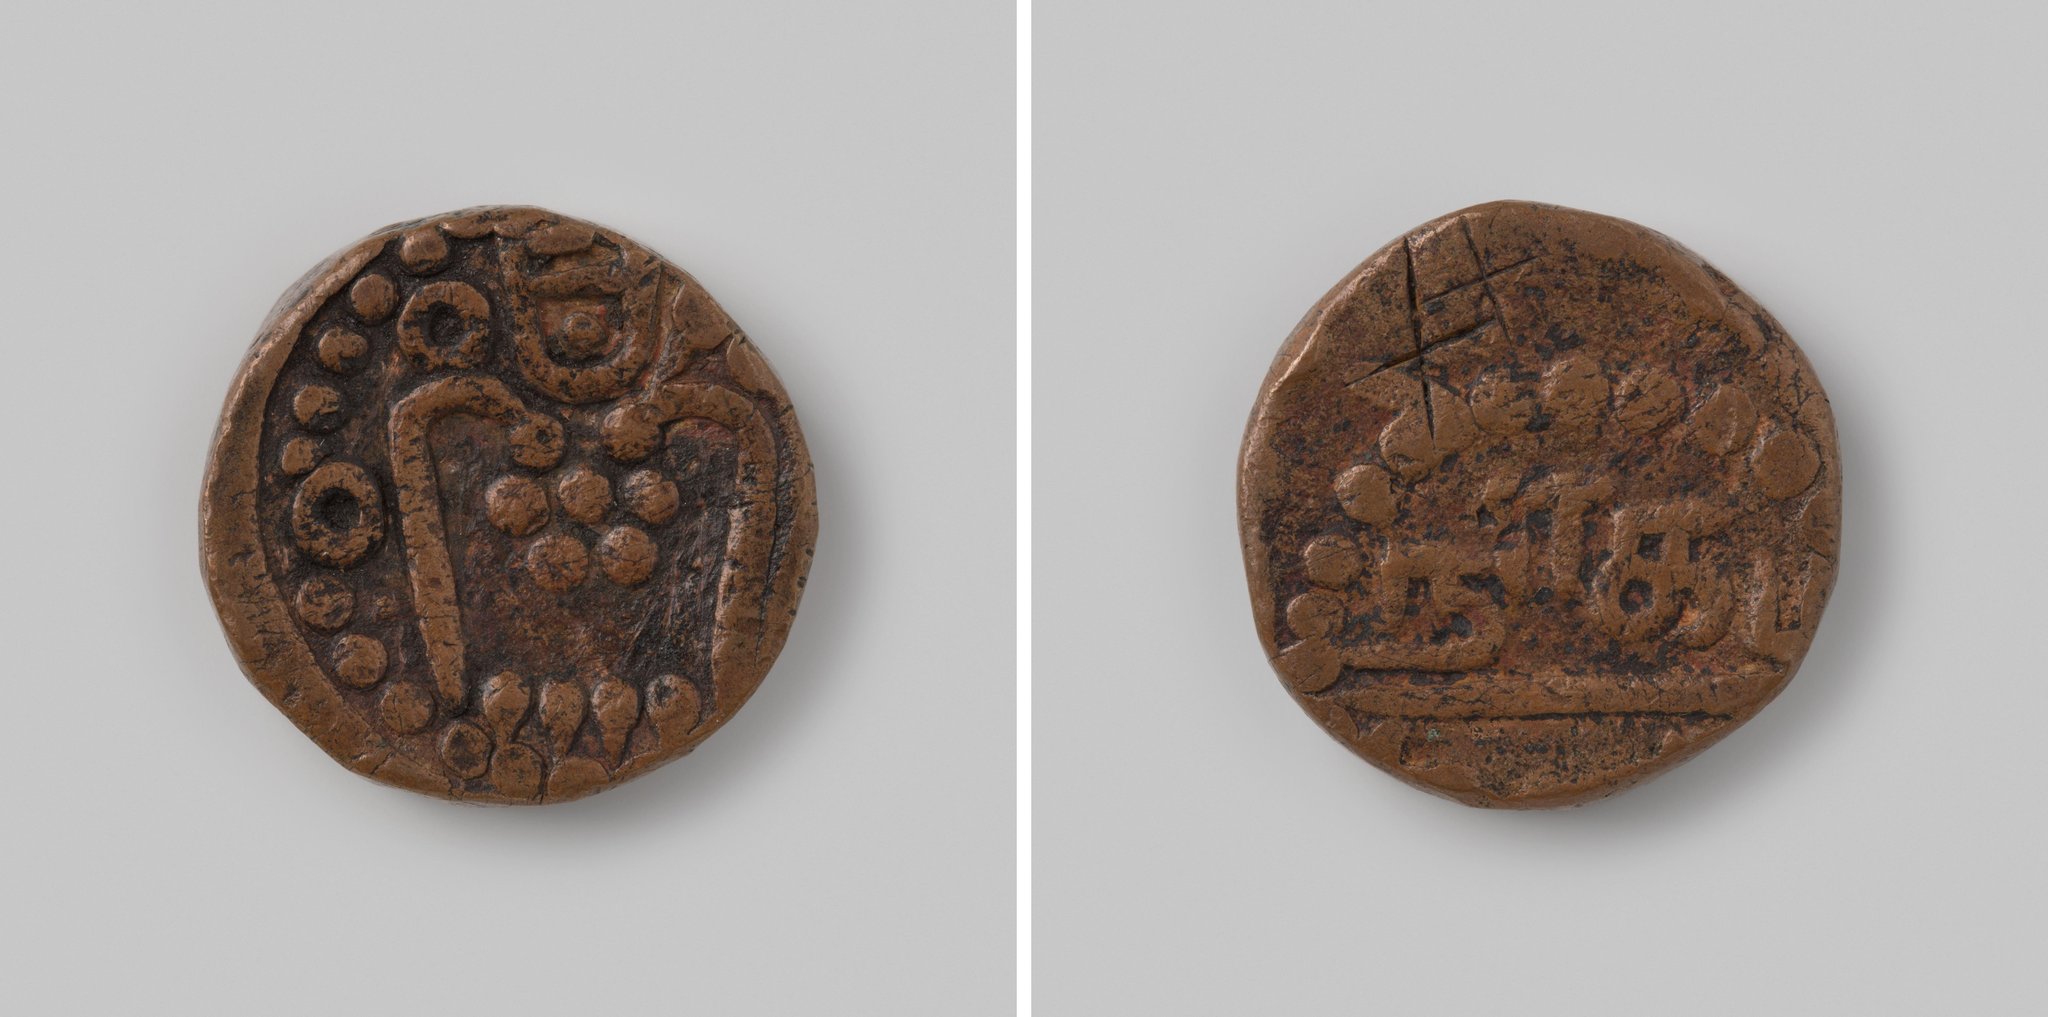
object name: coin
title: Negapatnam, dubbele stuiver voor Ceylon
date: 1695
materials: copper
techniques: striking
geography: negapatnam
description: Koperen munt. Voorzijde: verbasterde menselijke figuur (Kali). Boven de linkerschouder twee cirkels schuin boven elkaar. Keerzijde: tweeregelig opschrift in Tamil. Gladde rand.